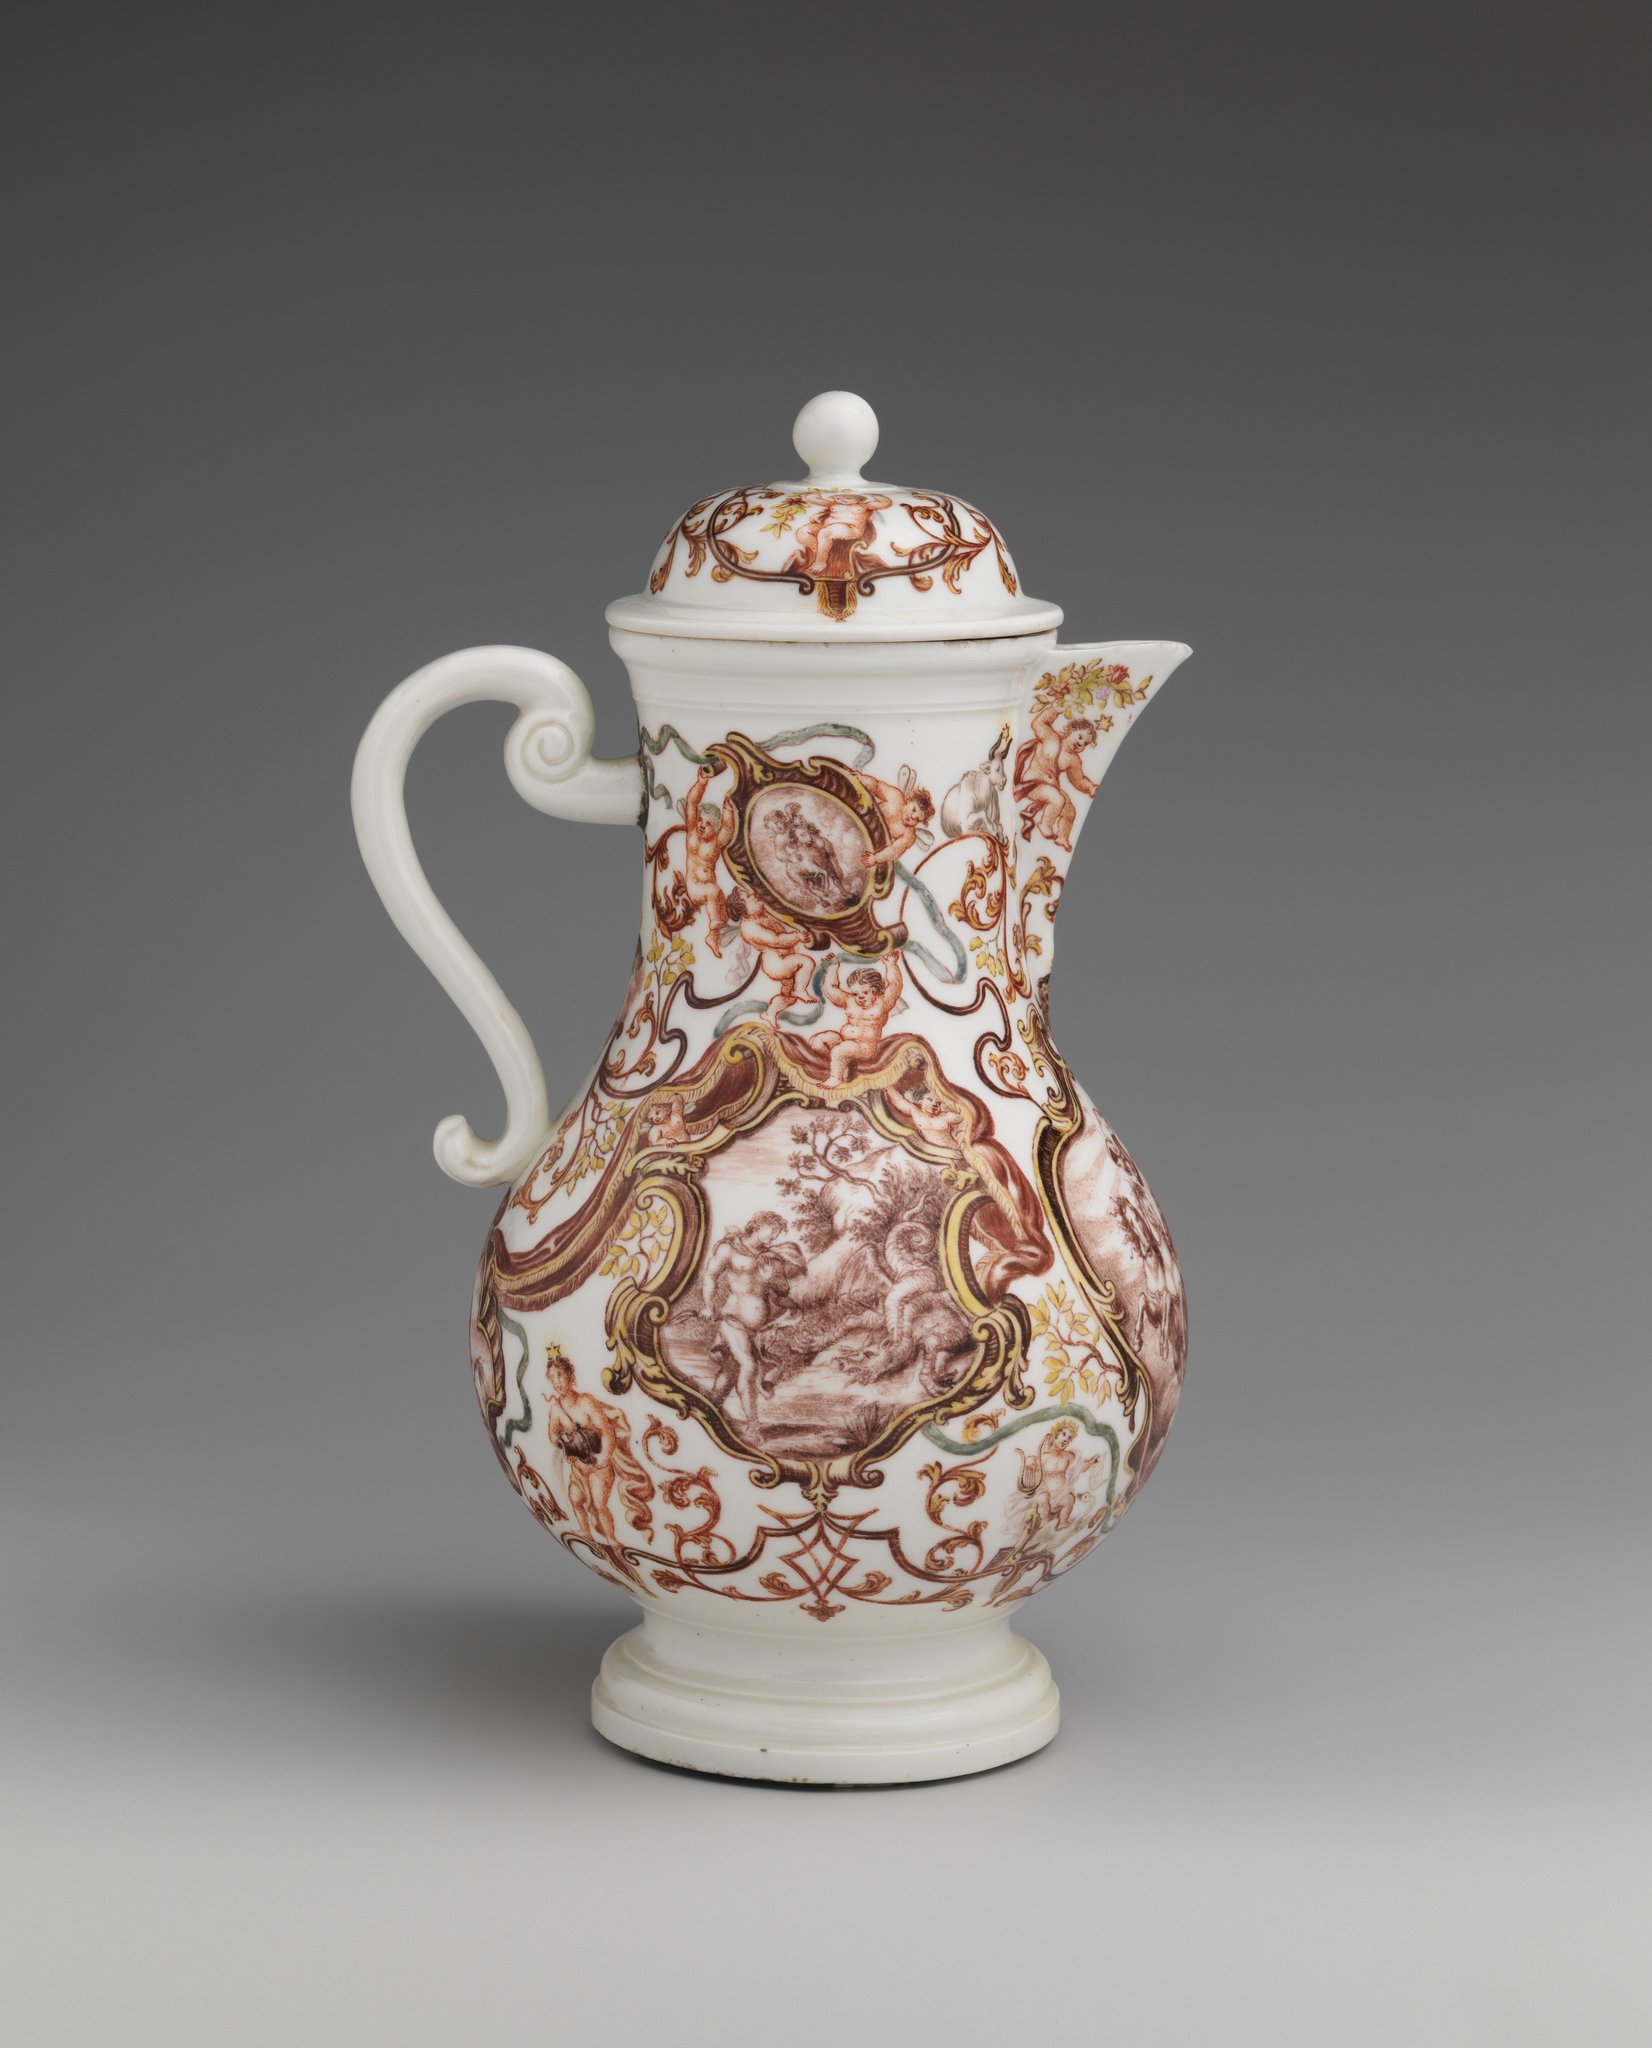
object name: coffeepot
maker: meissen manufactory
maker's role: manufactory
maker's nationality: german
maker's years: 1710-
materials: enamel, hard paste porcelain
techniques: polychrome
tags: animals,female nudes,dragons